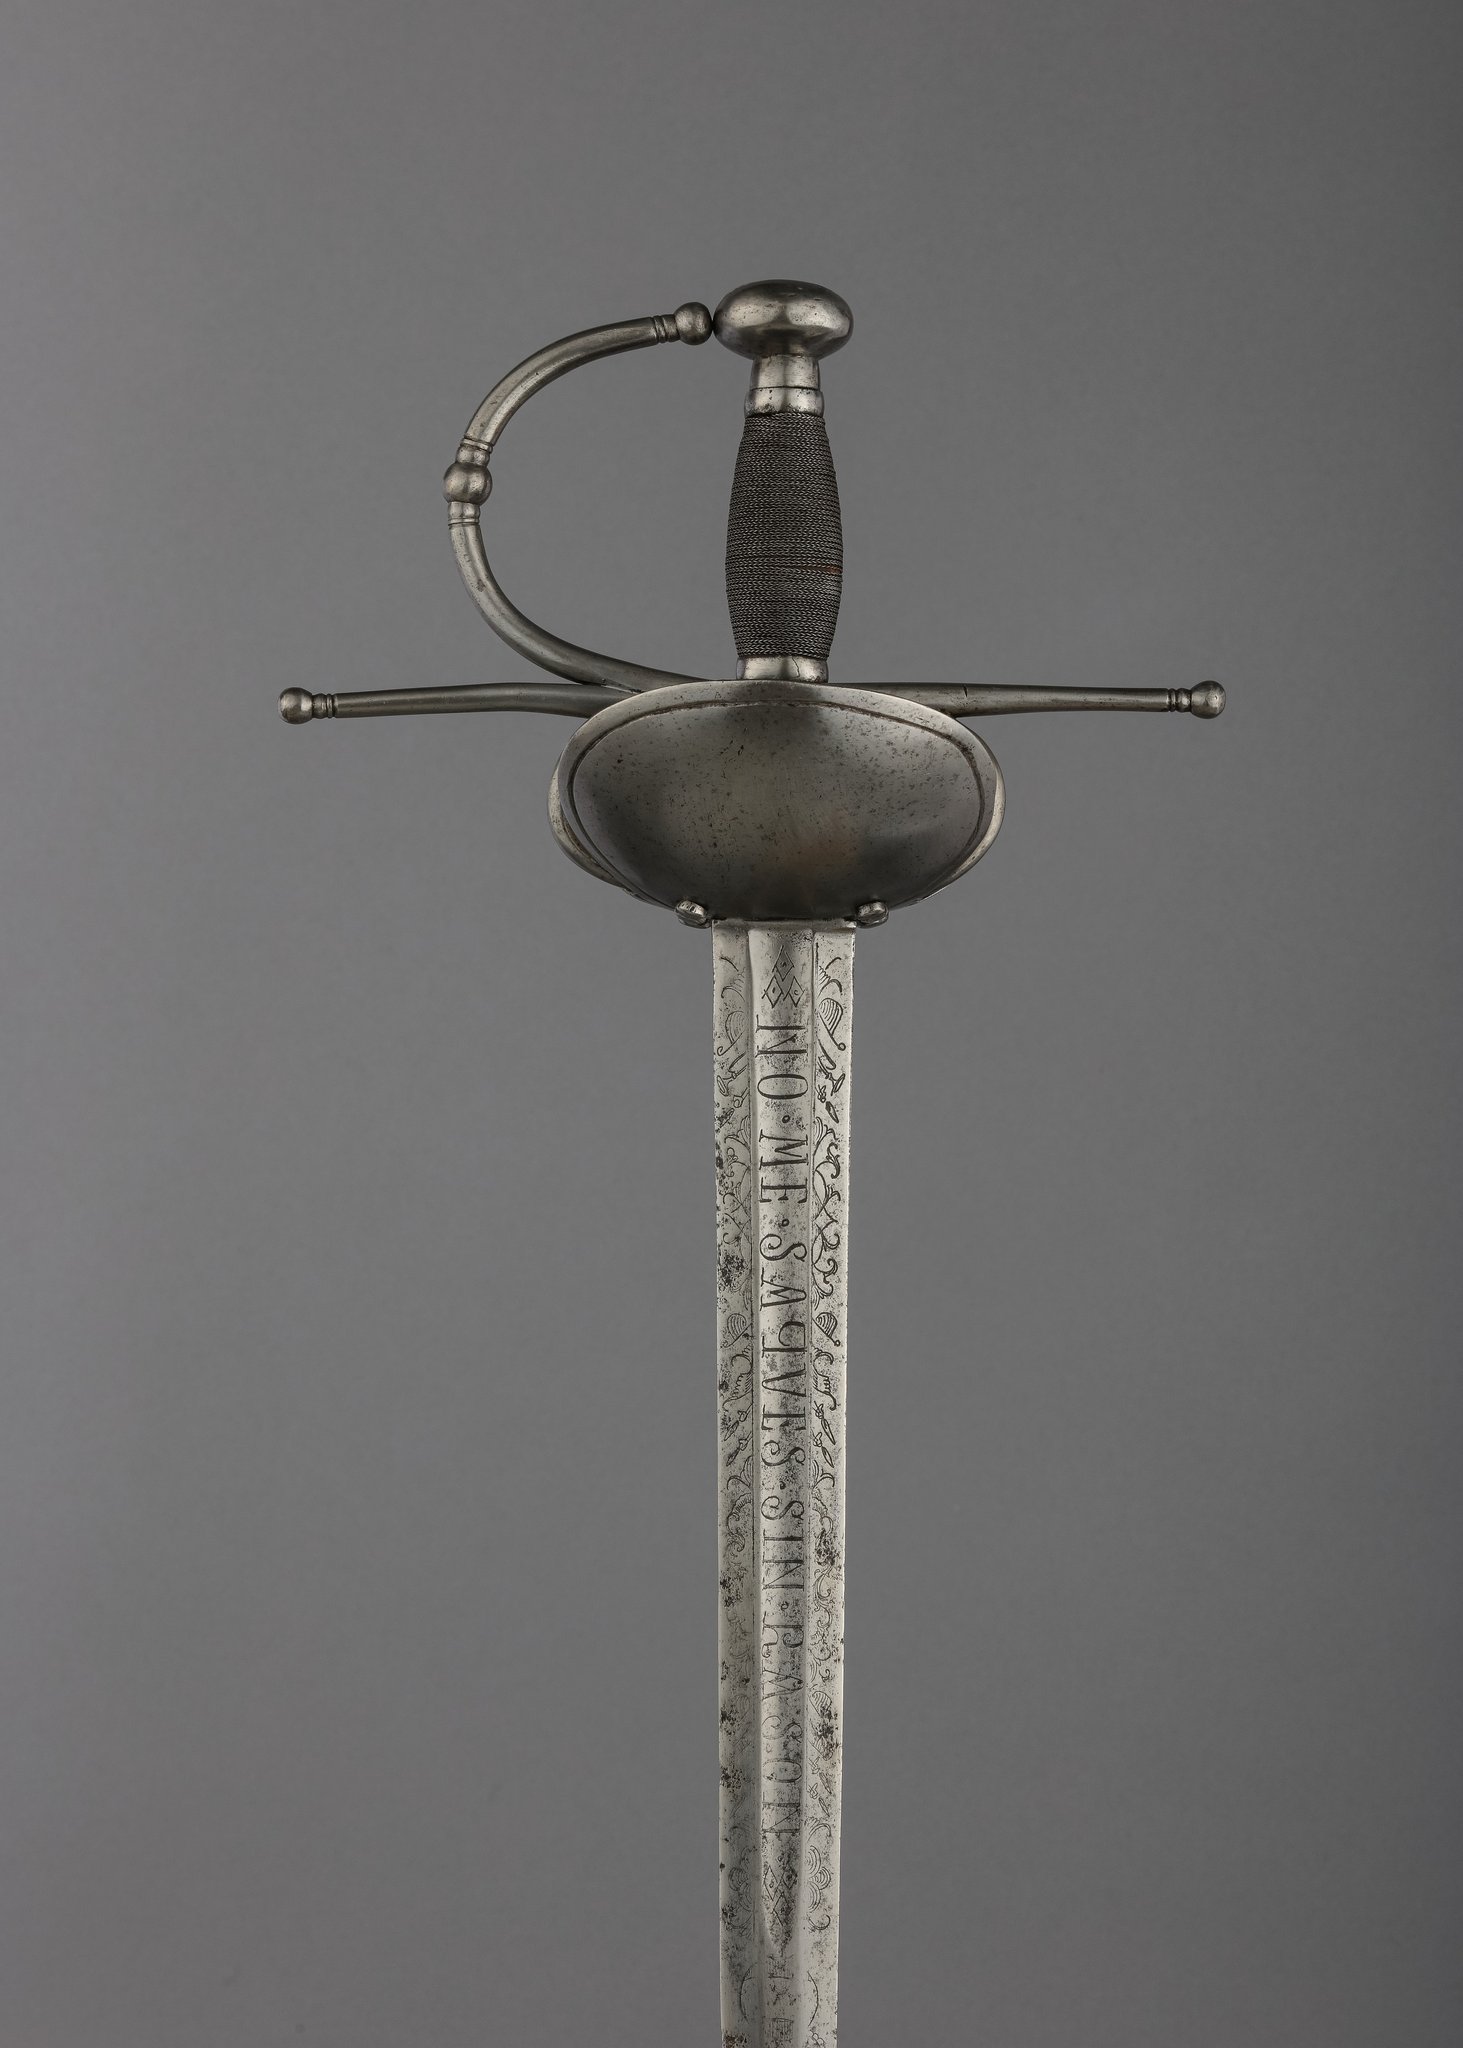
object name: rapier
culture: spanish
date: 1801-1900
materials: steel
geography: spain